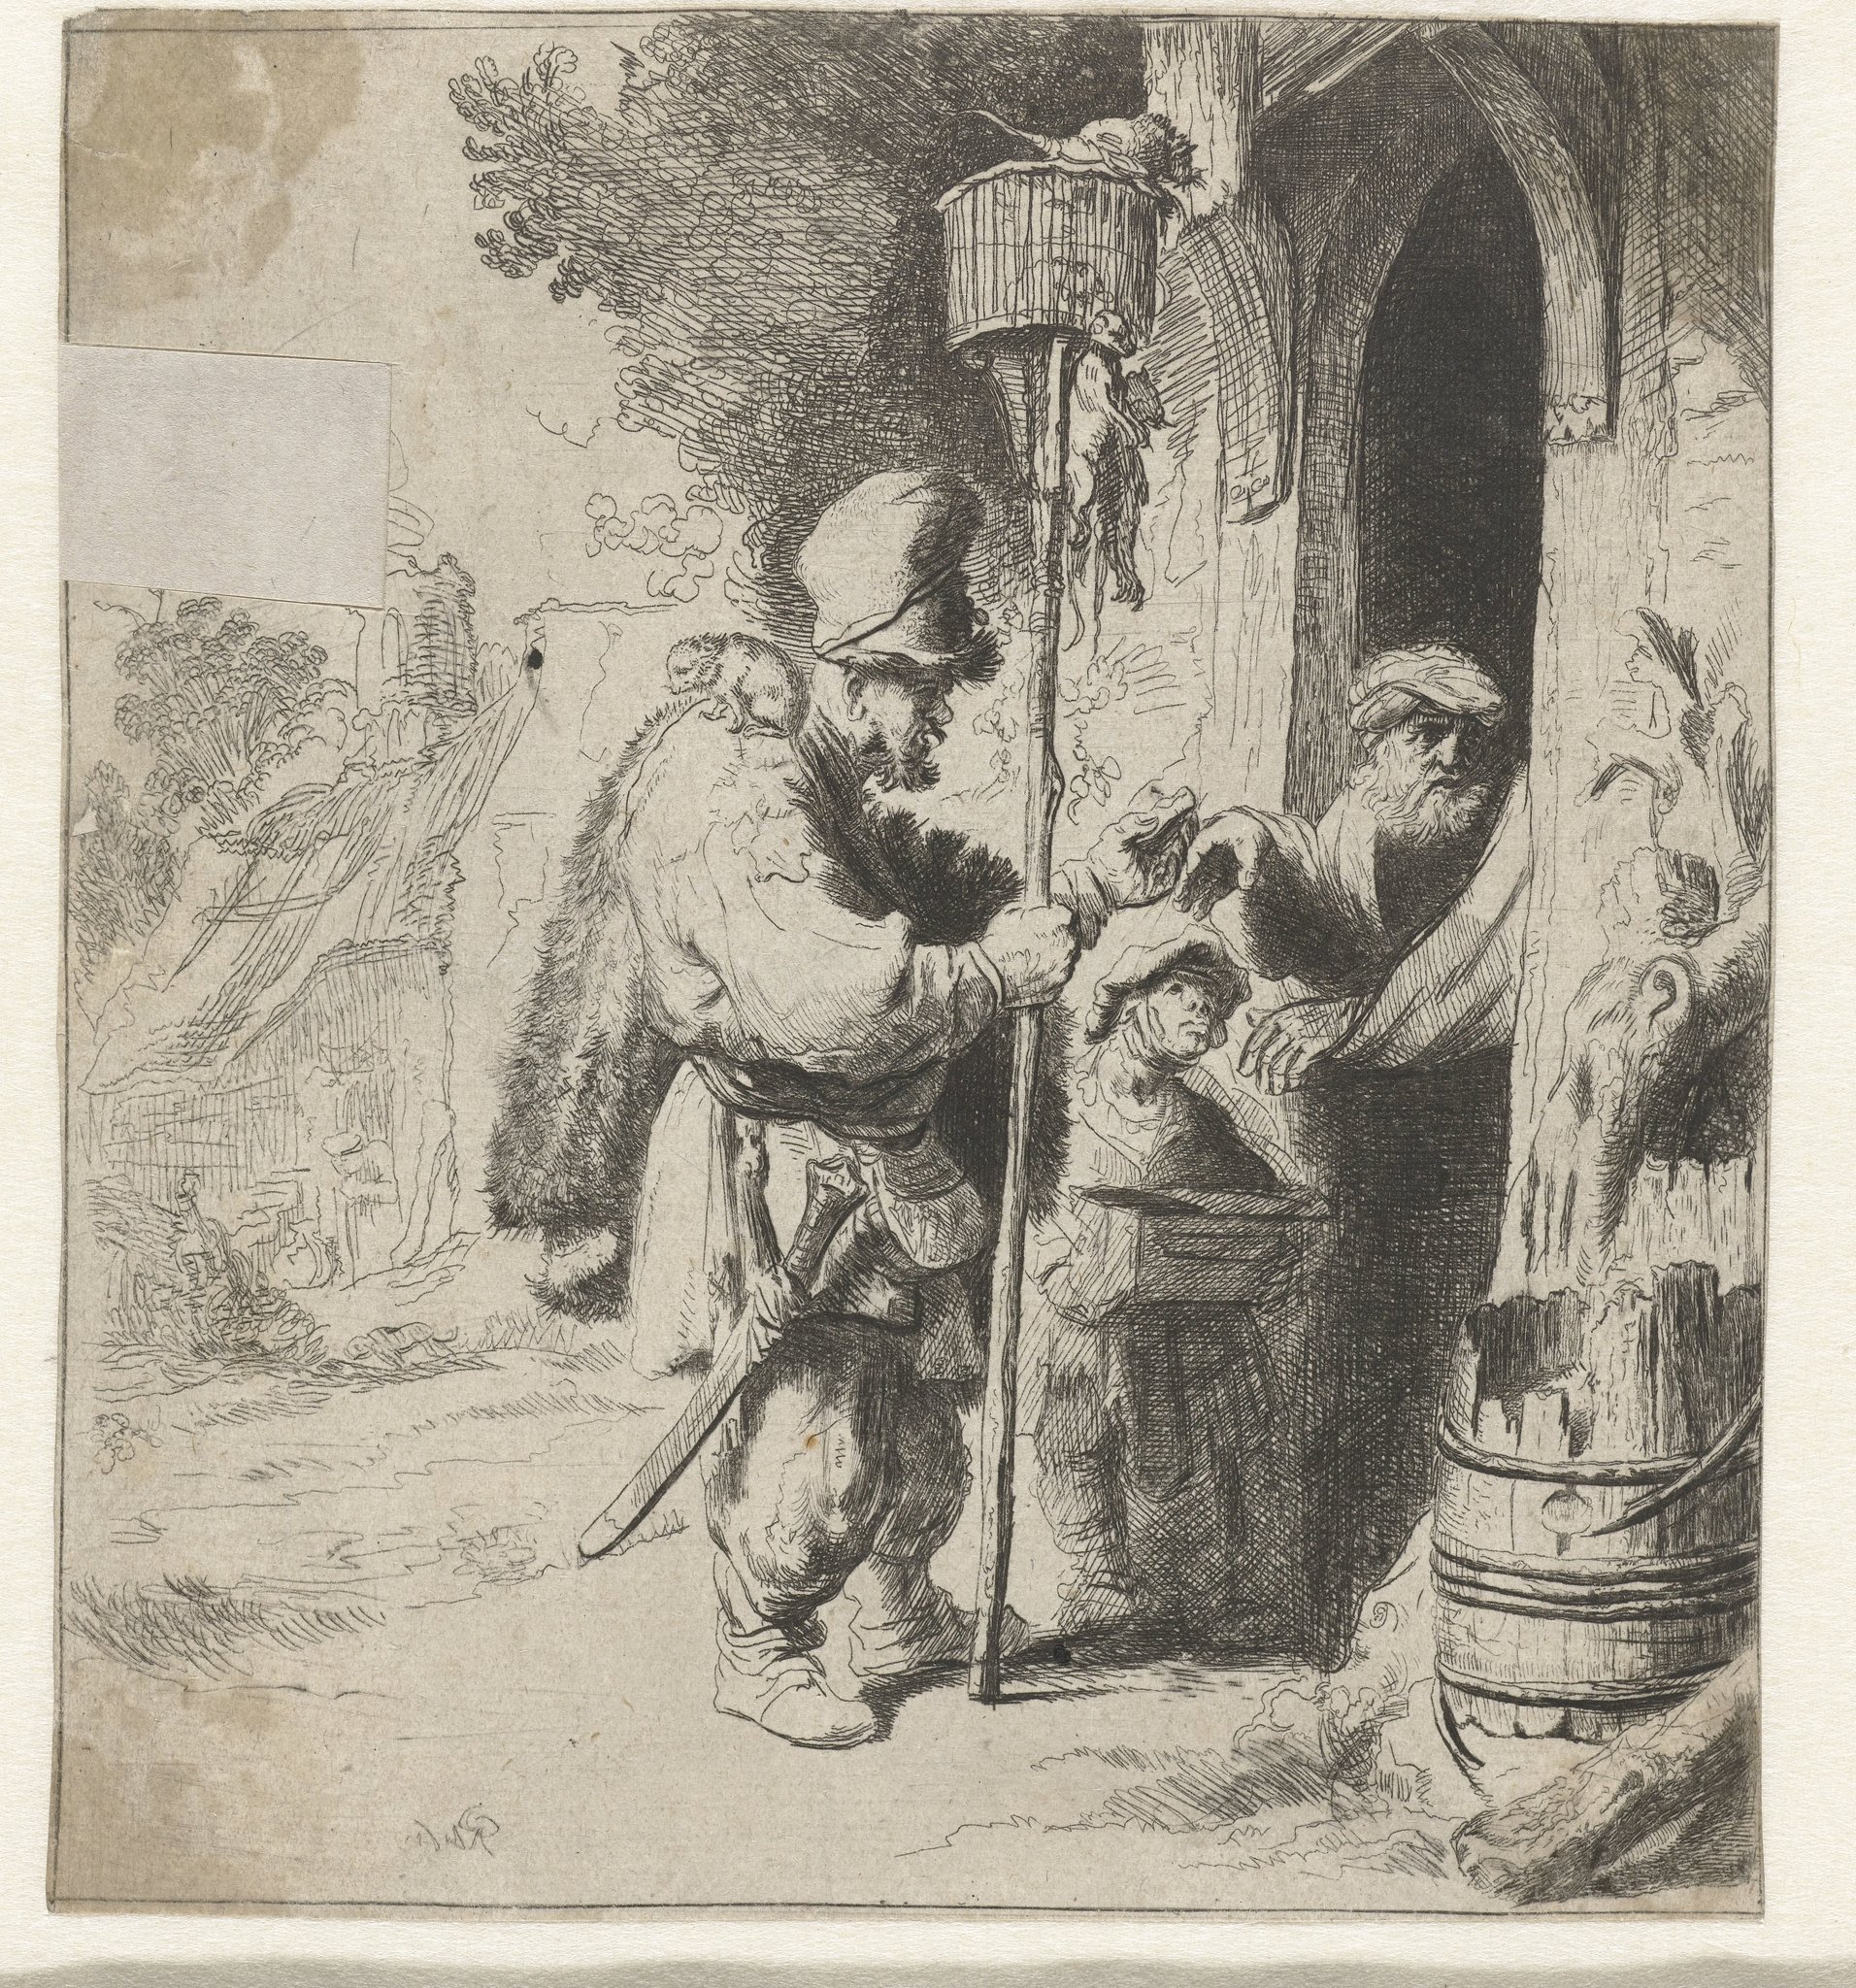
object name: print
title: The rat catcher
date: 1632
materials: paper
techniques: etching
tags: rat exterminator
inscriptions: collector's mark: Lugt 2760, collector's mark: Lugt 2228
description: Spiegelbeeldige kopie naar de gelijknamige prent van Rembrandt.